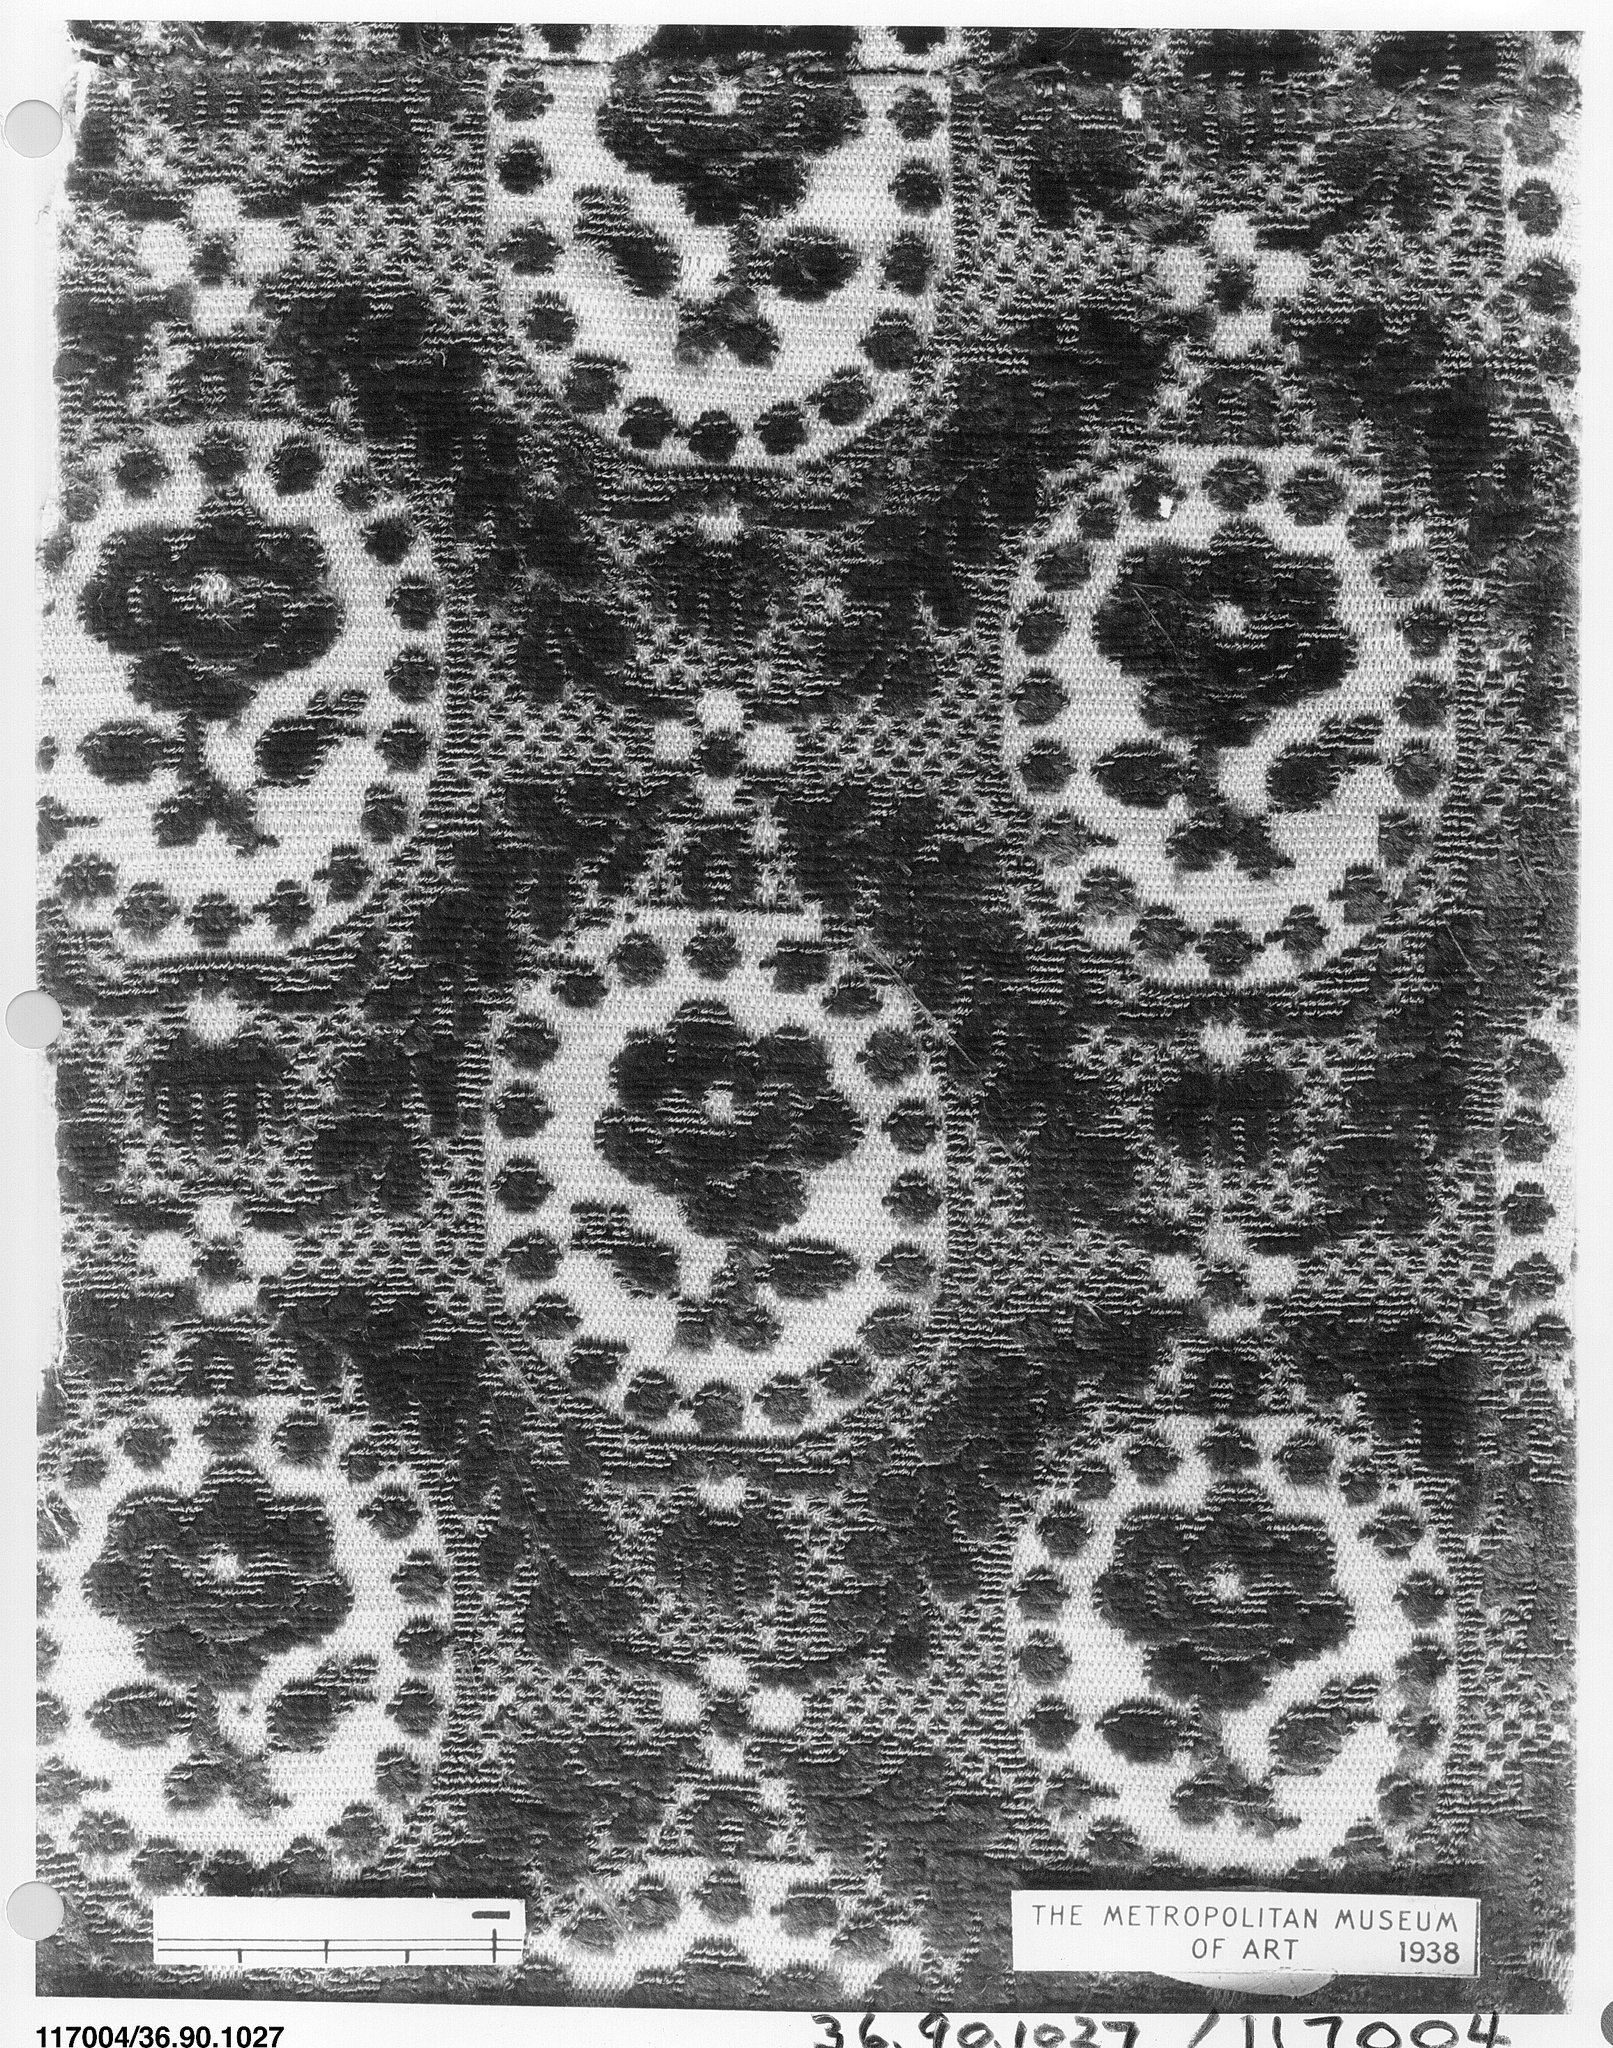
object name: piece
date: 1701-1800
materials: silk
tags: flowers